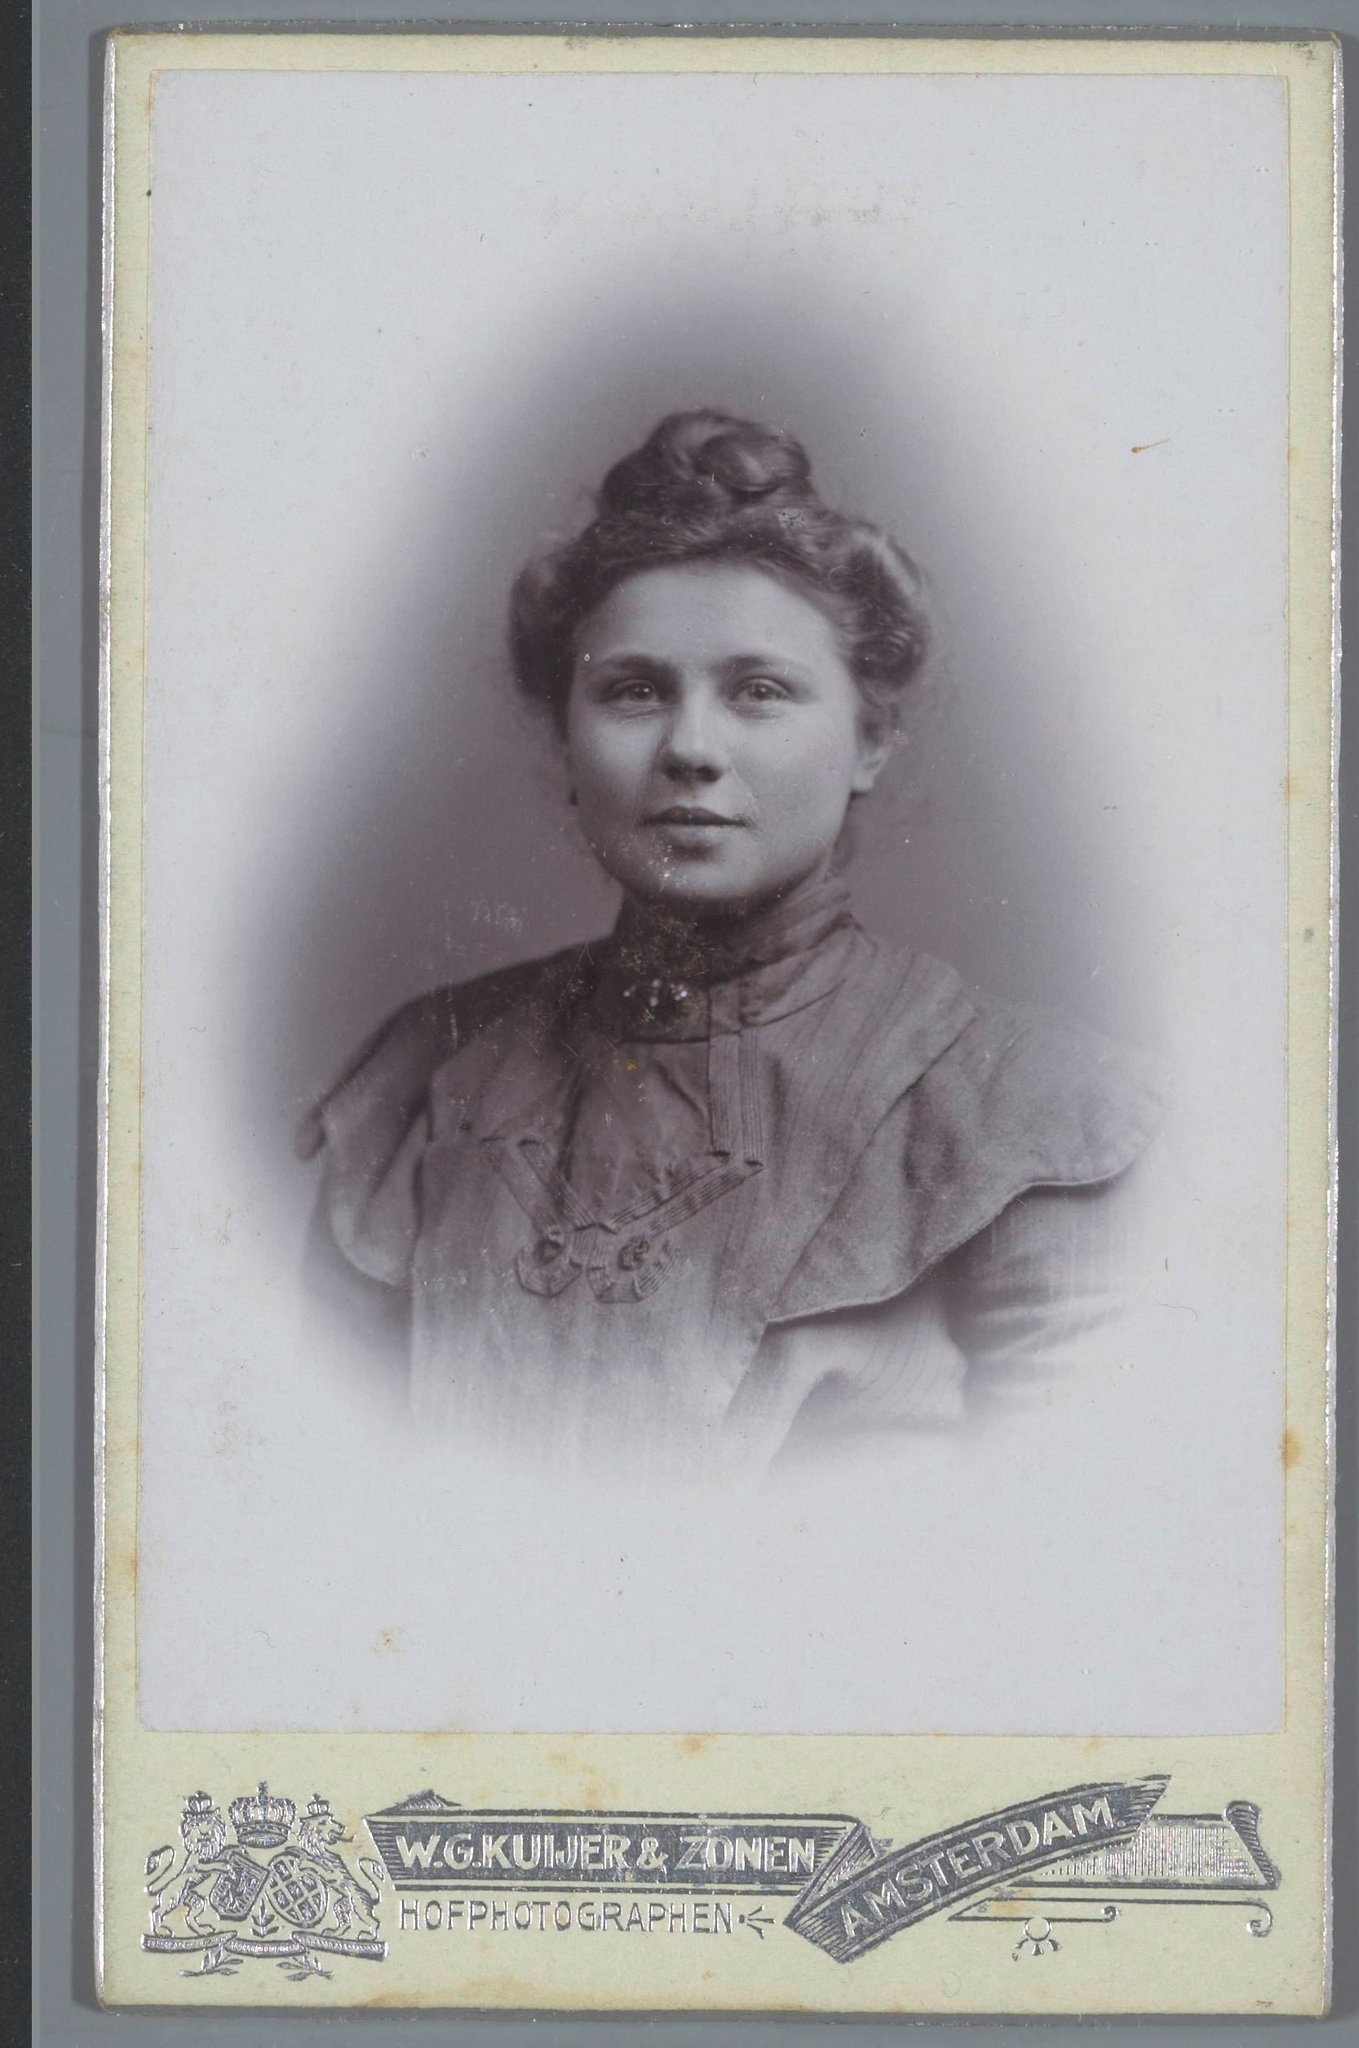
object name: carte de visite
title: Portret van een onbekende vrouw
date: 1880-1906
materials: paper, cardboard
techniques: collodion silver print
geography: amsterdam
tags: adult woman, anonymous historical person portrayed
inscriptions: inscription: ‘OPGERICHT 1864/ 17/ Spéciale Inrichting voor Vergrootingen in alle Formaten.’, address: ‘Westermarkt 19. Amsterdam’